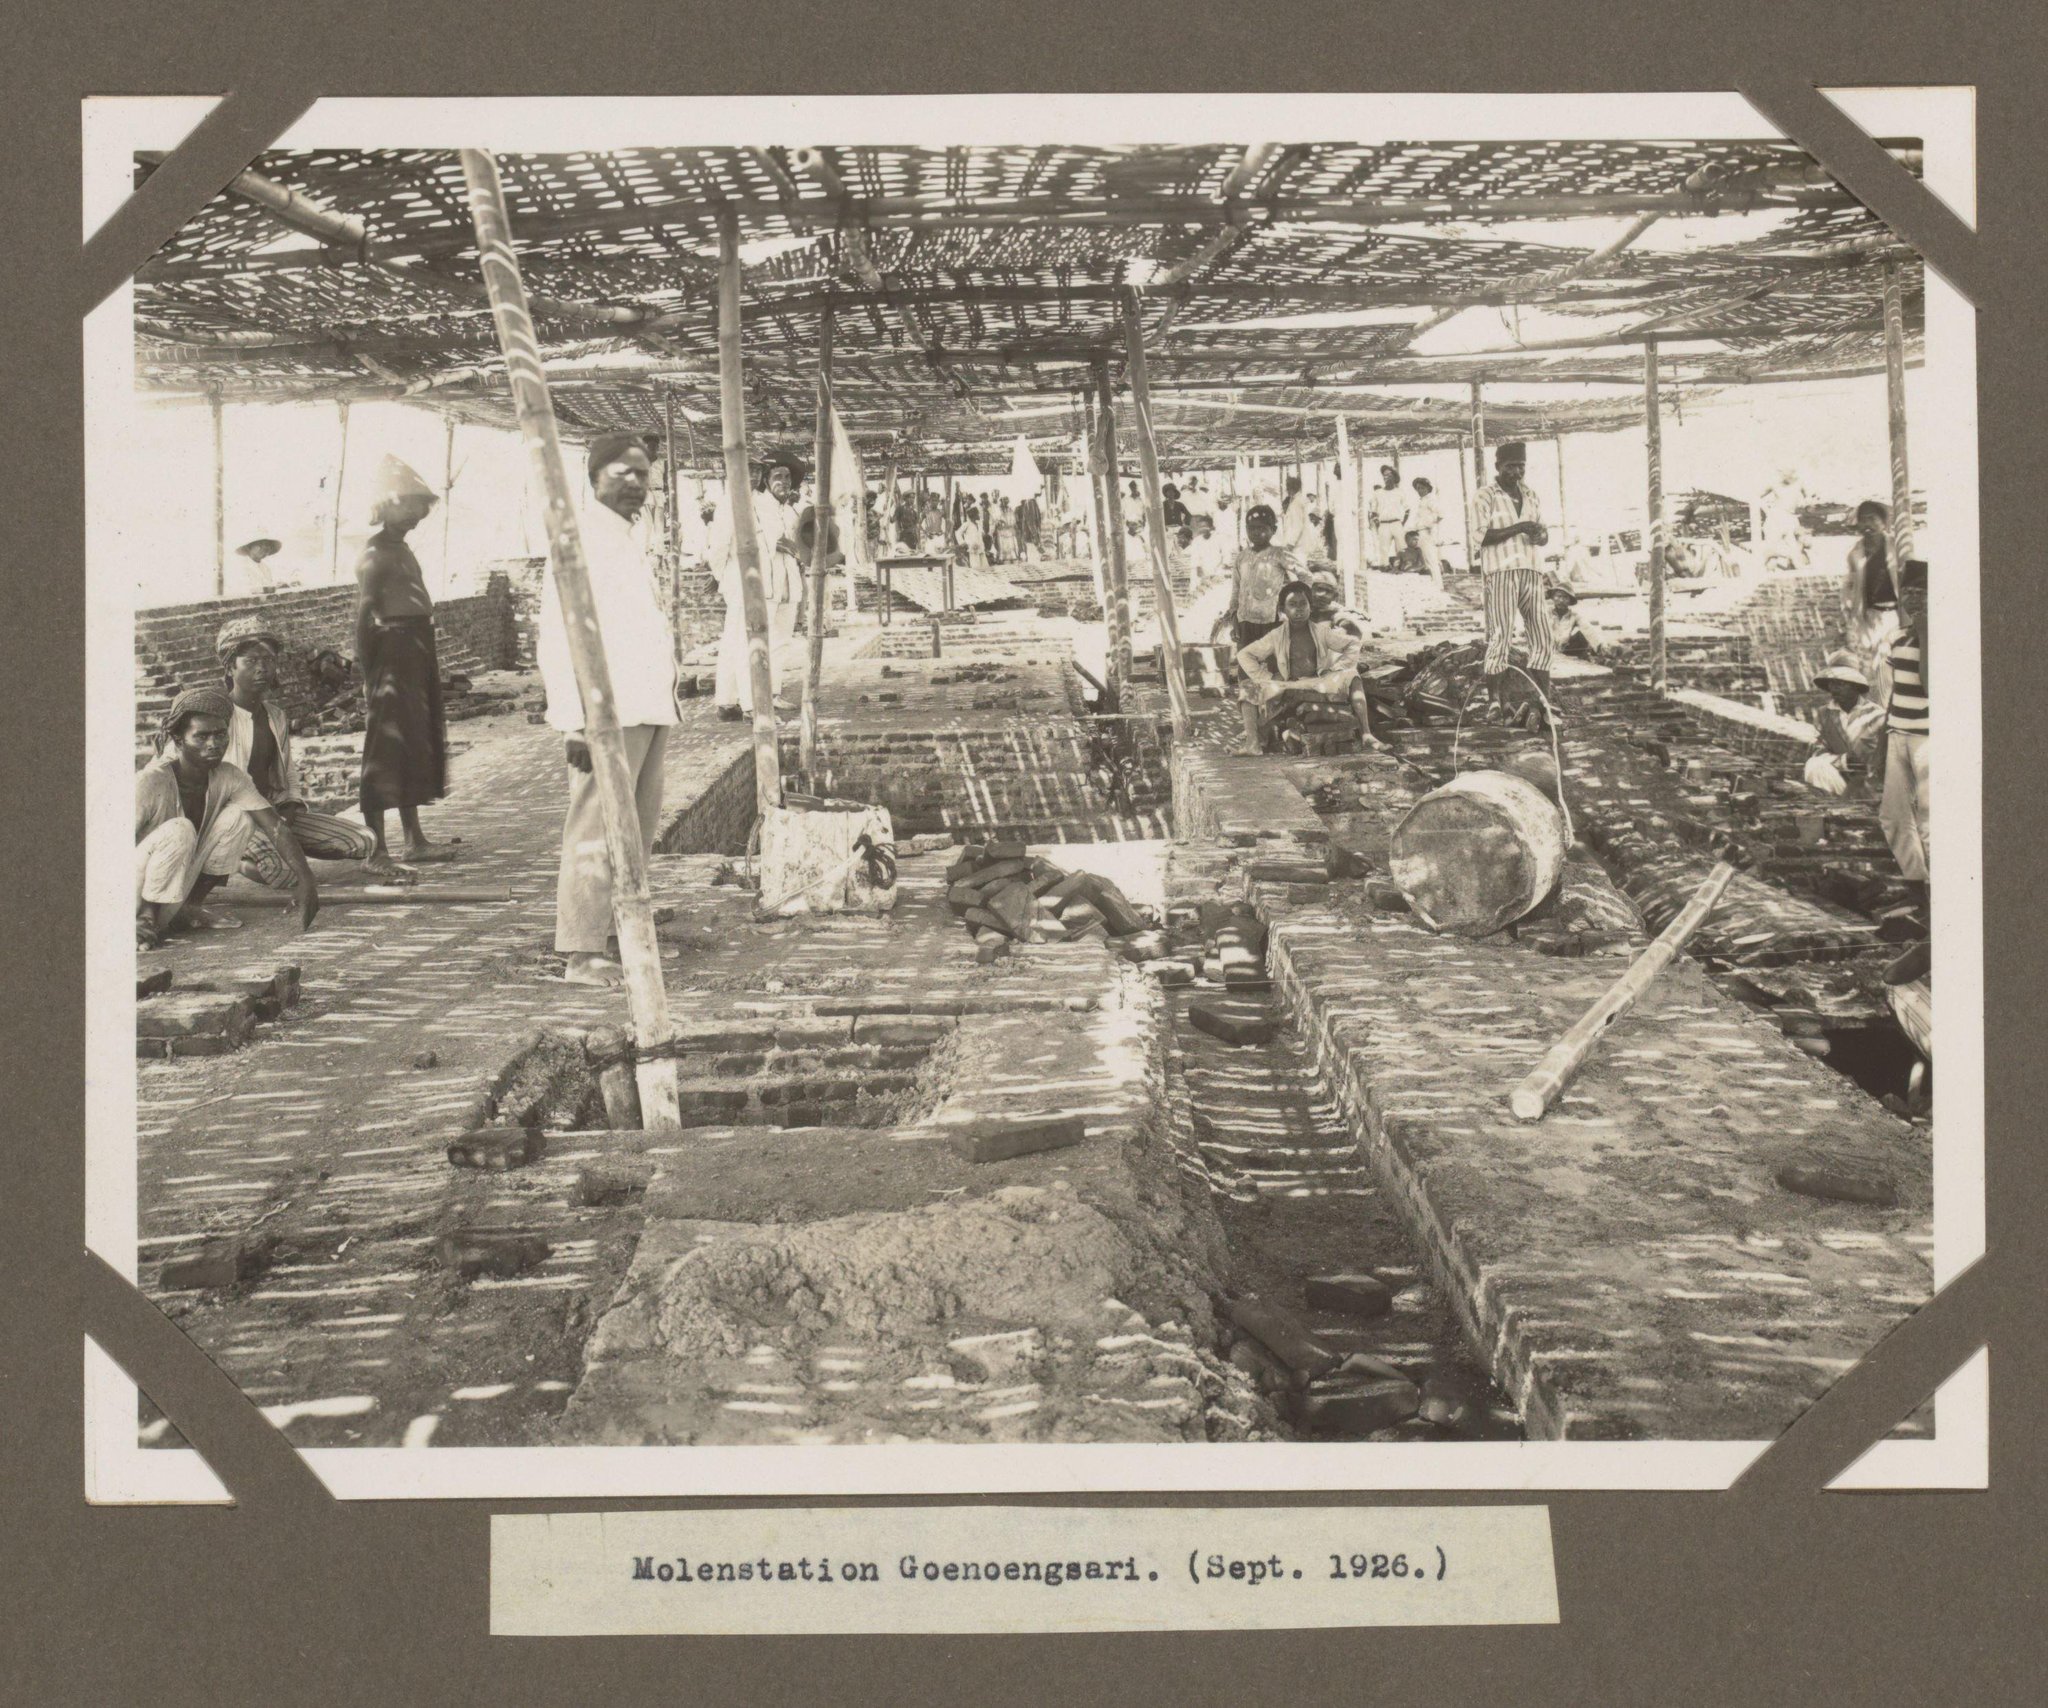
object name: photograph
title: Molenstation Goenoengsari. (Sept. 1926.)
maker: Anonymous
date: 1909-1926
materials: photographic support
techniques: gelatin silver print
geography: east java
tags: colonial system, trade-company, factory-interior, machine shop, making the overground structures (~ building activities), (non-fruit) products of plants or trees: sugarcane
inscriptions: inscription: ‘Molenstation Goenoengsari. (Sept. 1926.)’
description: Bouw van het molenstation voor de fabriek, september 1926. Onderdeel van het fotoalbum met foto's van de opbouw van de suikerfabriek te Goenoengsari op Oost-Java door de Handels Vereniging Amsterdam 1926-1927.